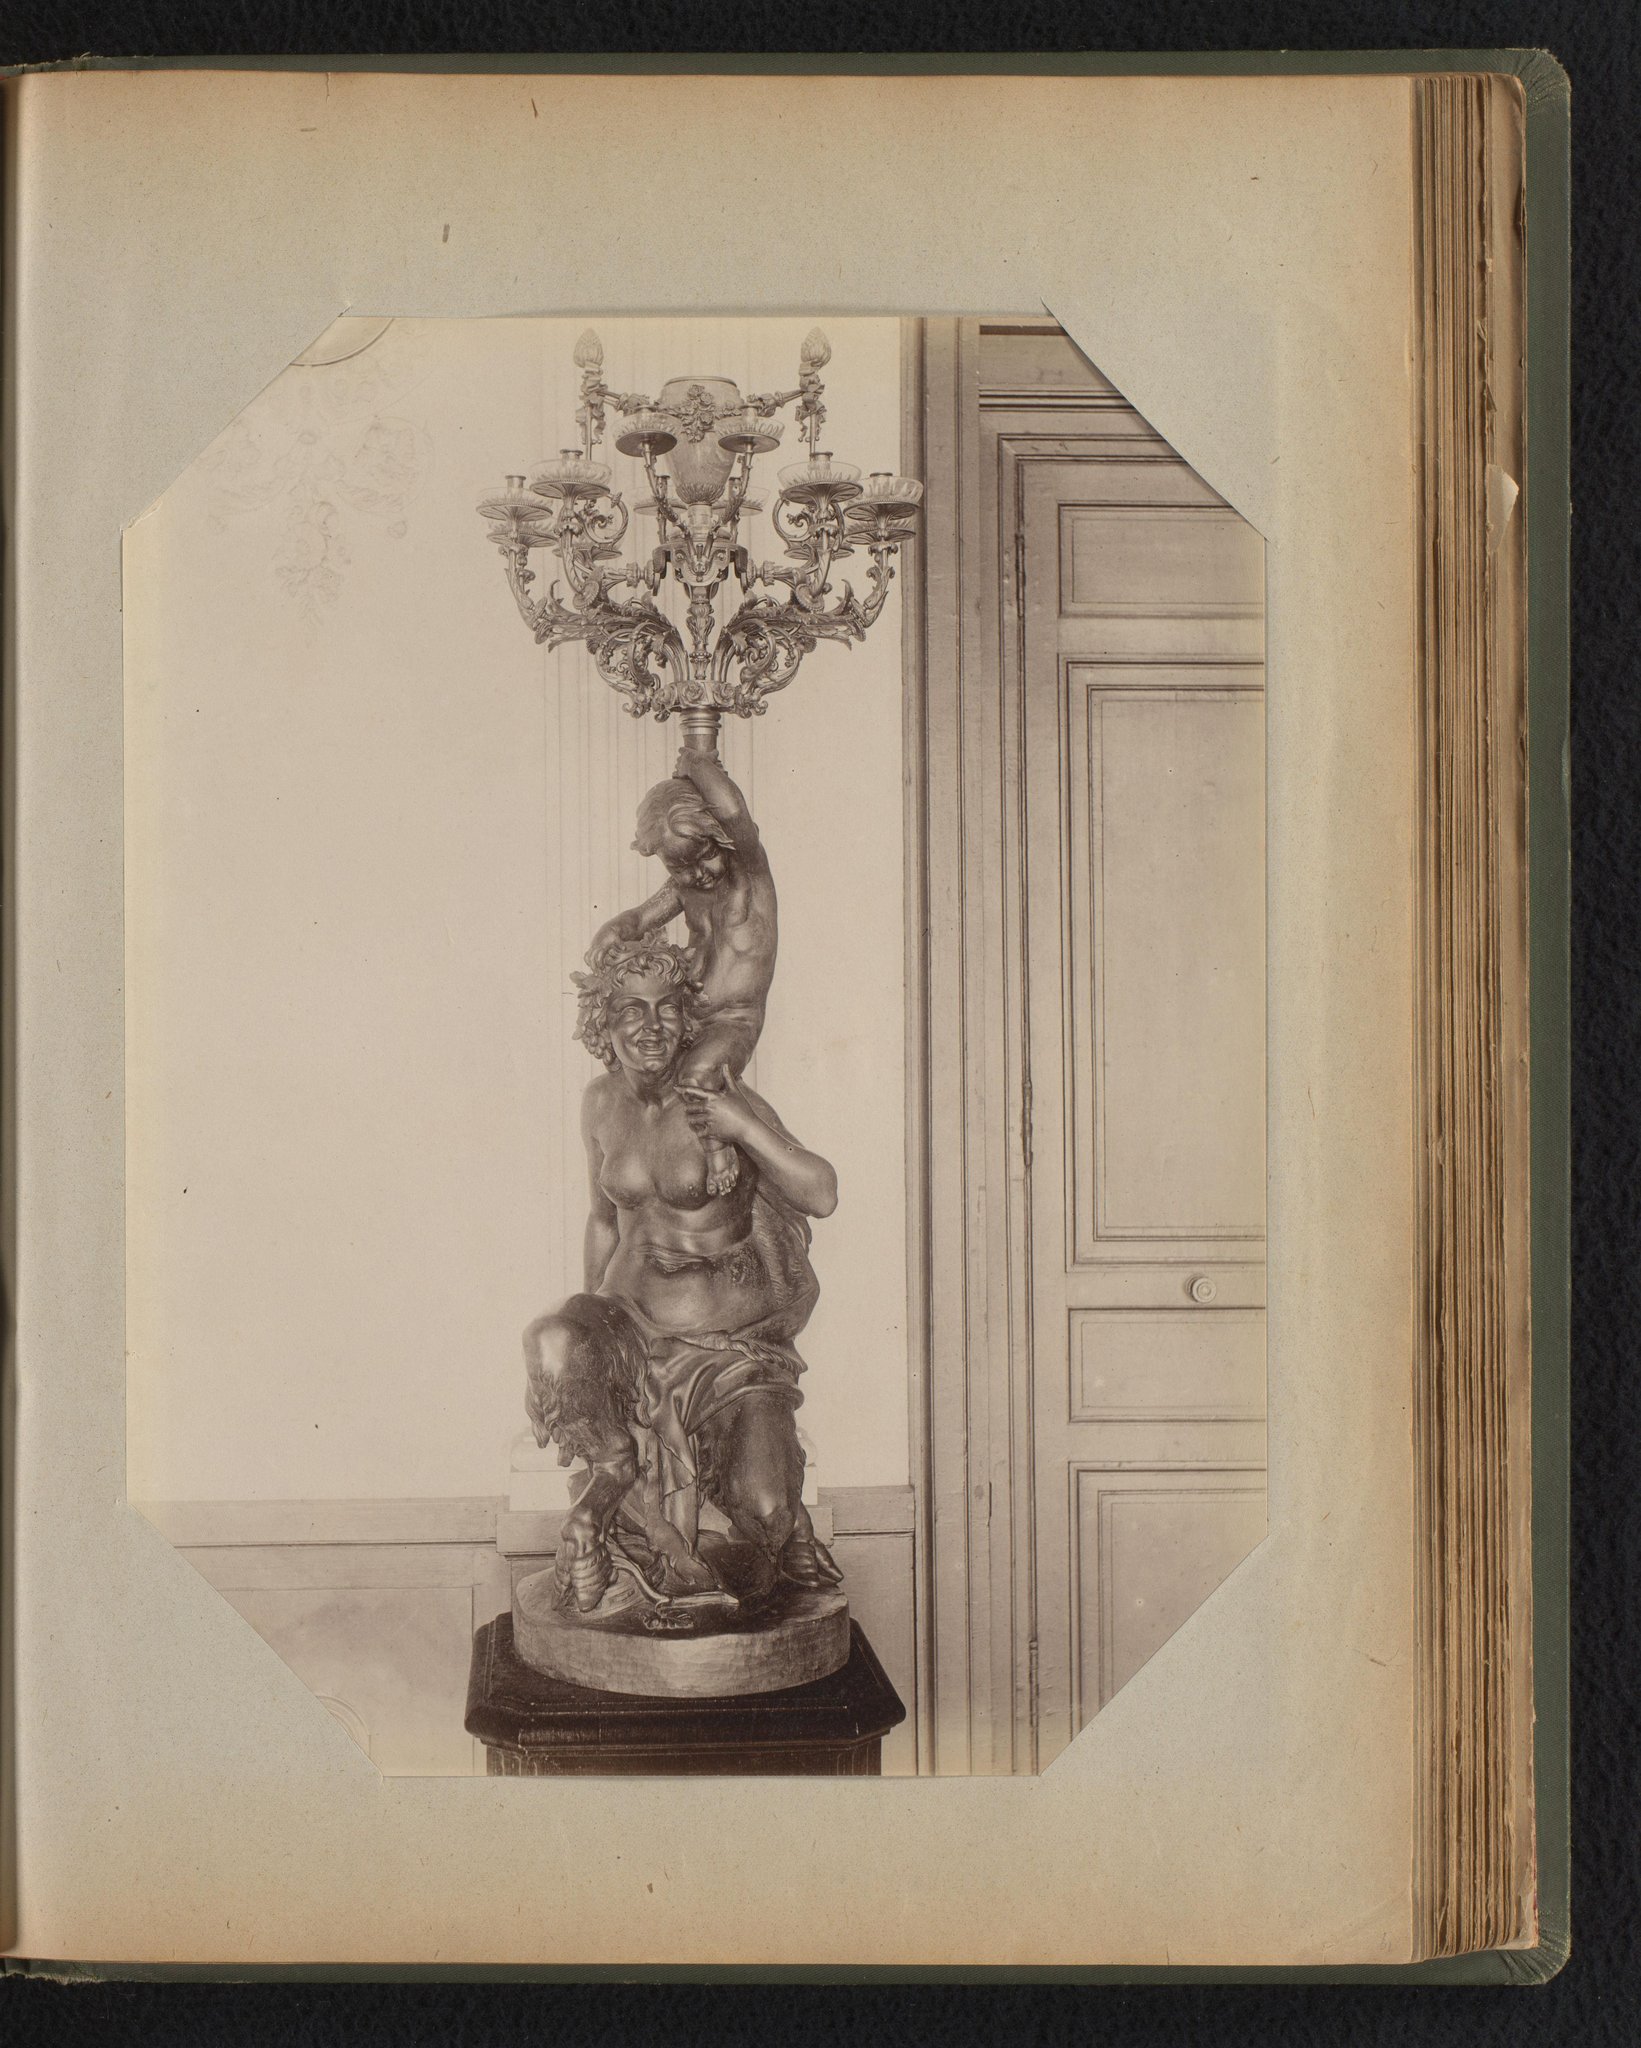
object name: photograph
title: Tienarmige bronzen kandelaar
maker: Anonymous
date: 1860-1900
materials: paper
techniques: albumen print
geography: france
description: De kandelaar wordt omhoog gehouden door een bronzen jongetje op de schouders van een vrouwelijk faun. Om de kandelaars zijn kristallen druppelvangers aangedracht.